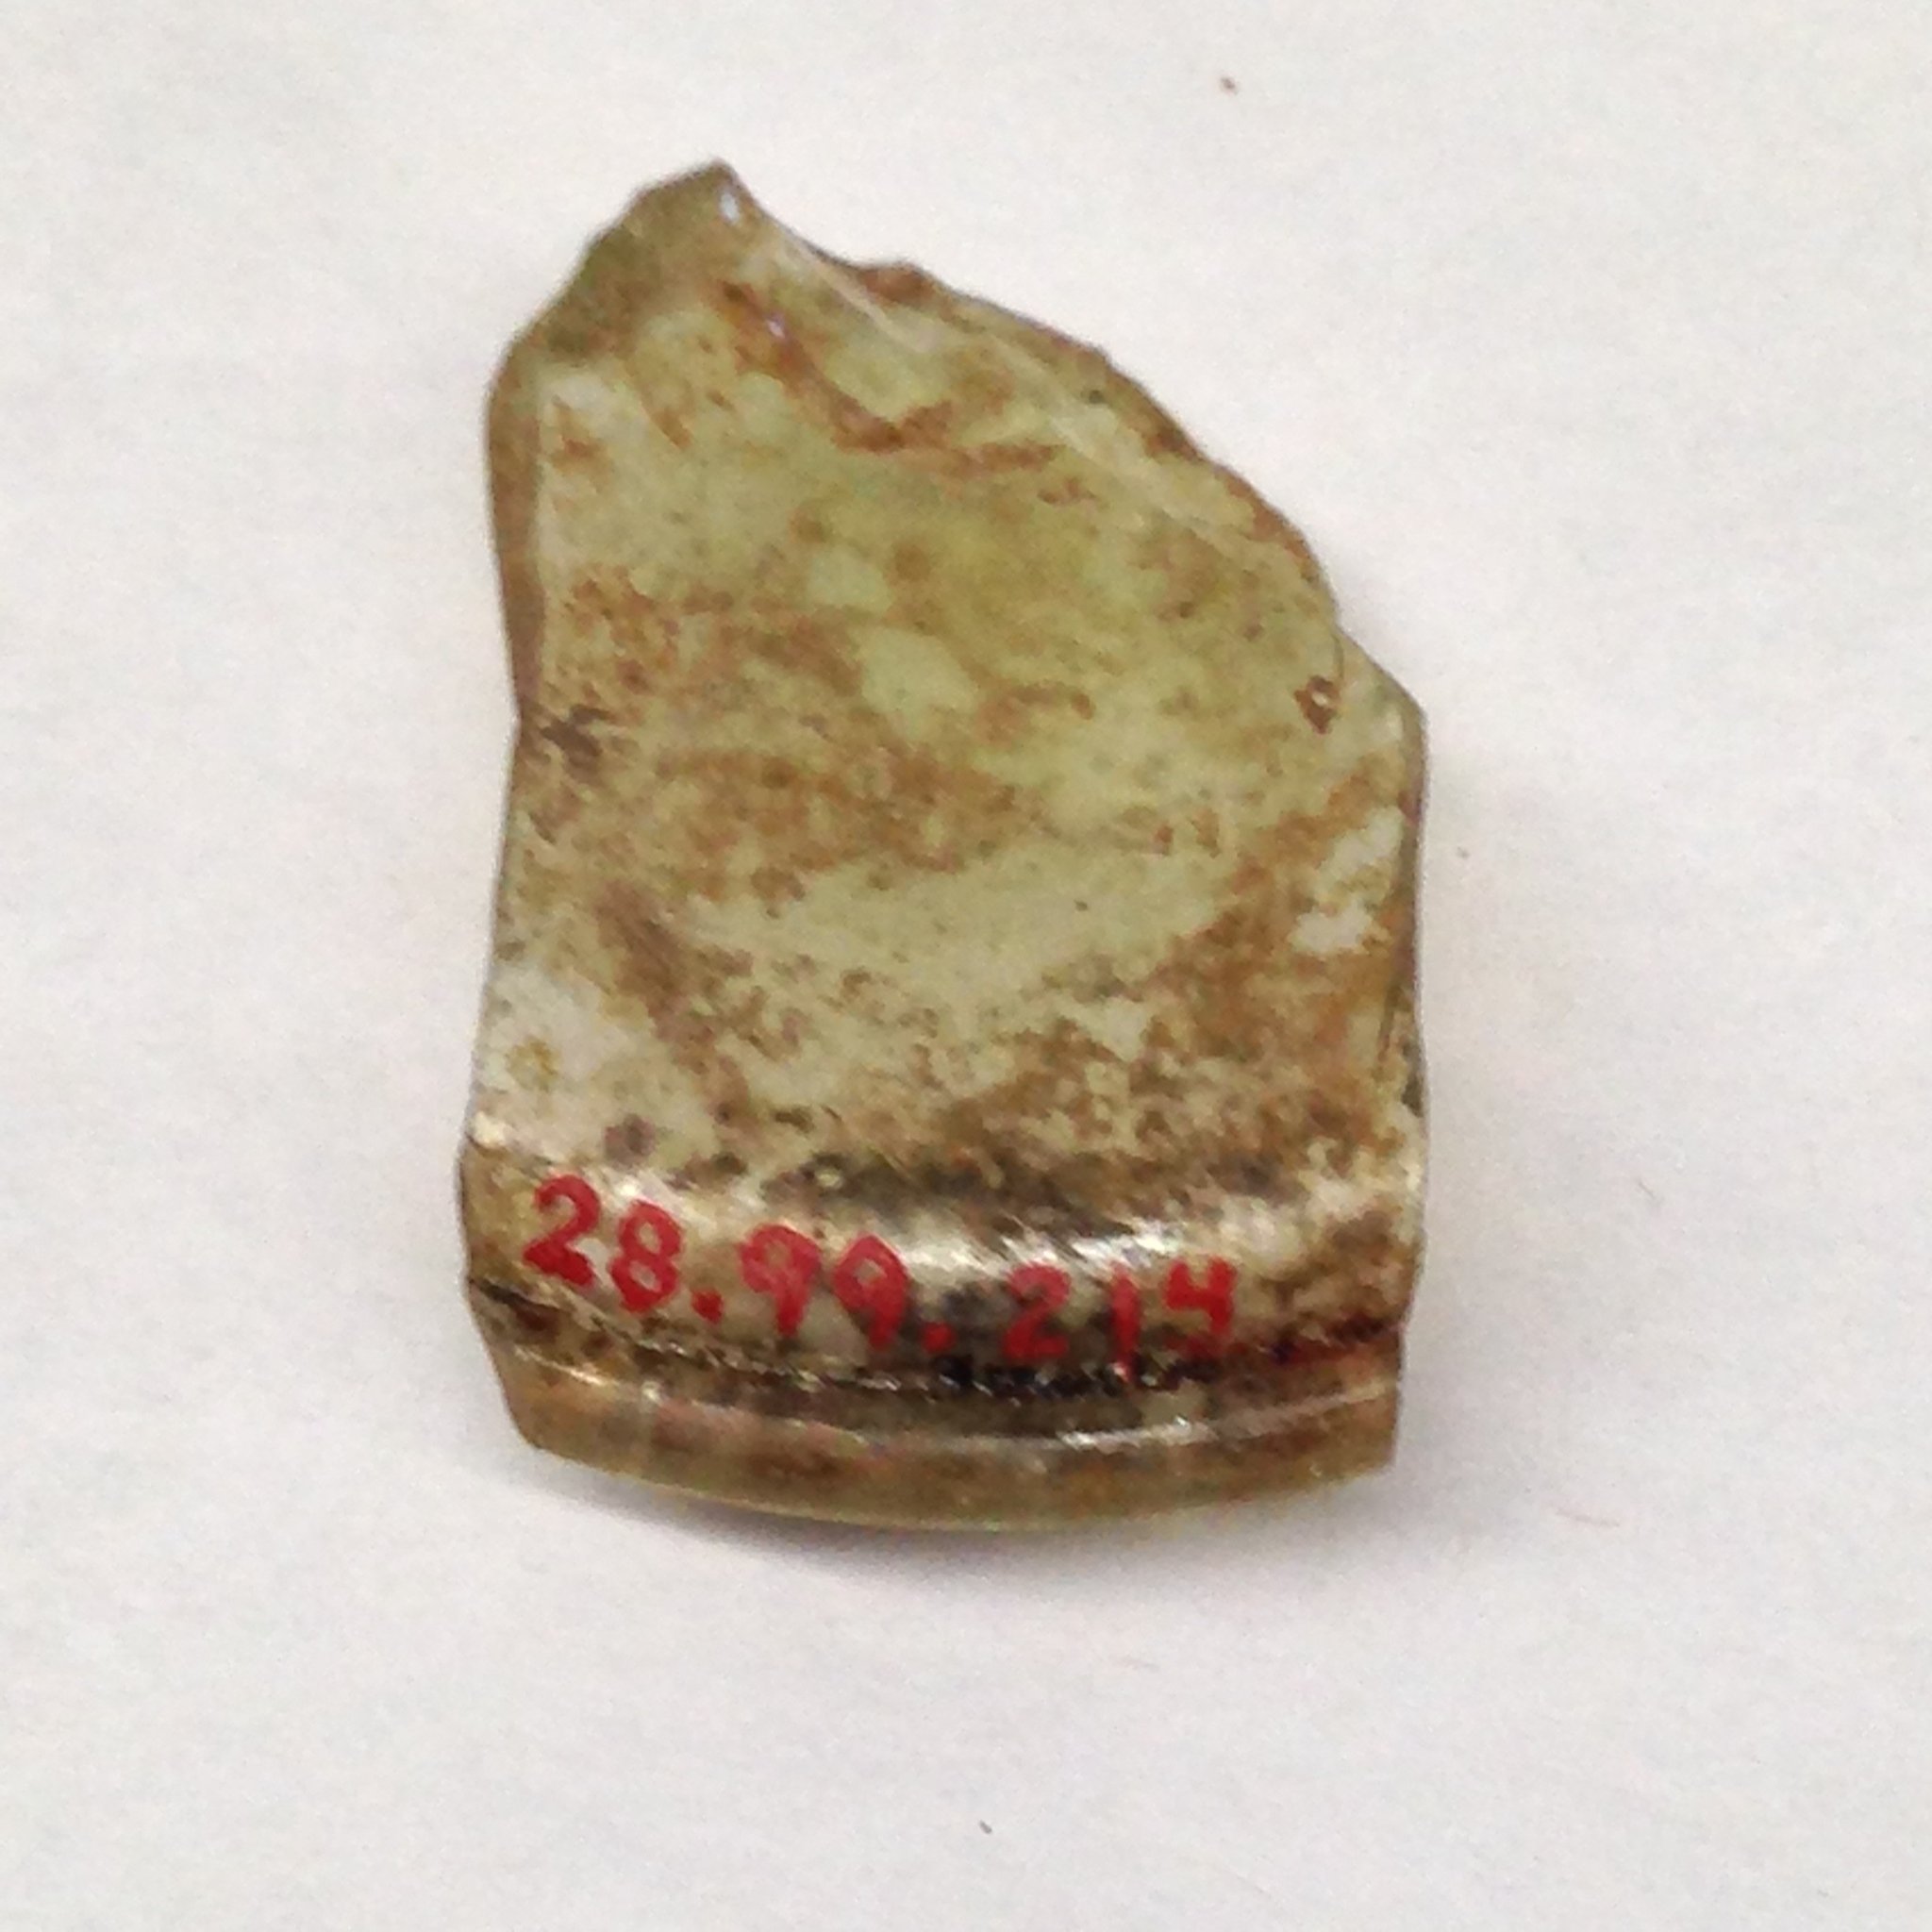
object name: fragment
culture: european or middle eastern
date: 1150-1250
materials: ceramic, glass